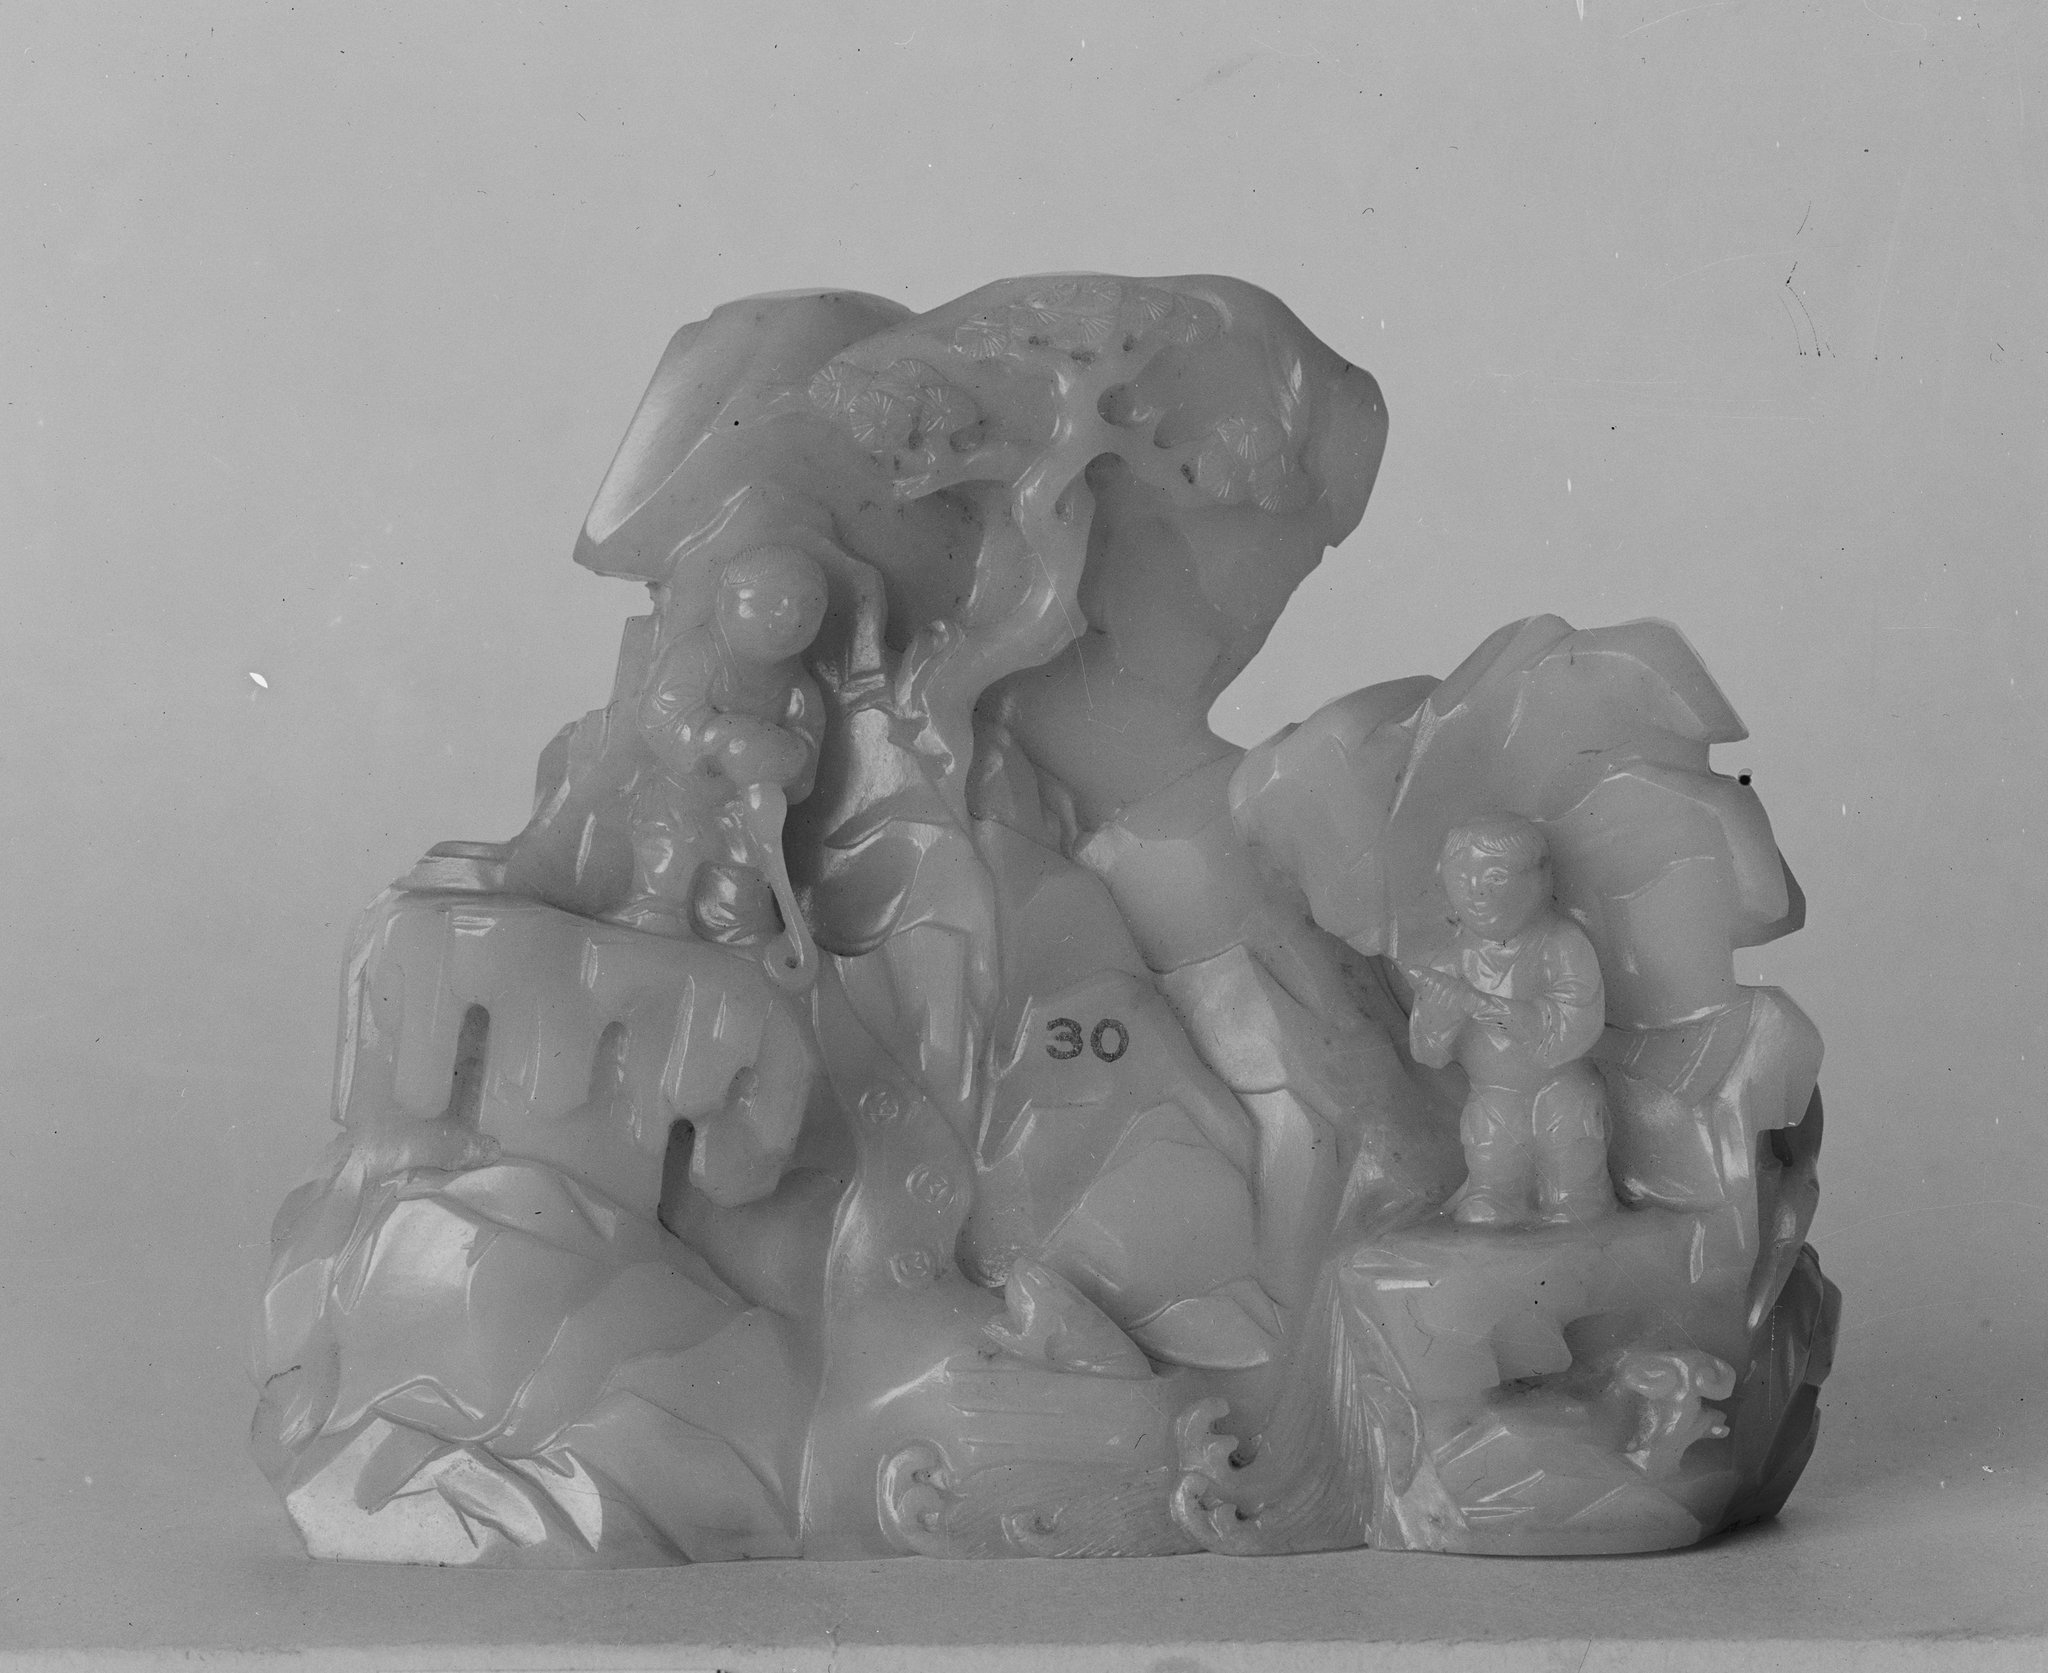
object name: figurine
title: Mountain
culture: chinese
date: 1736-1795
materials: jade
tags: men,mountains